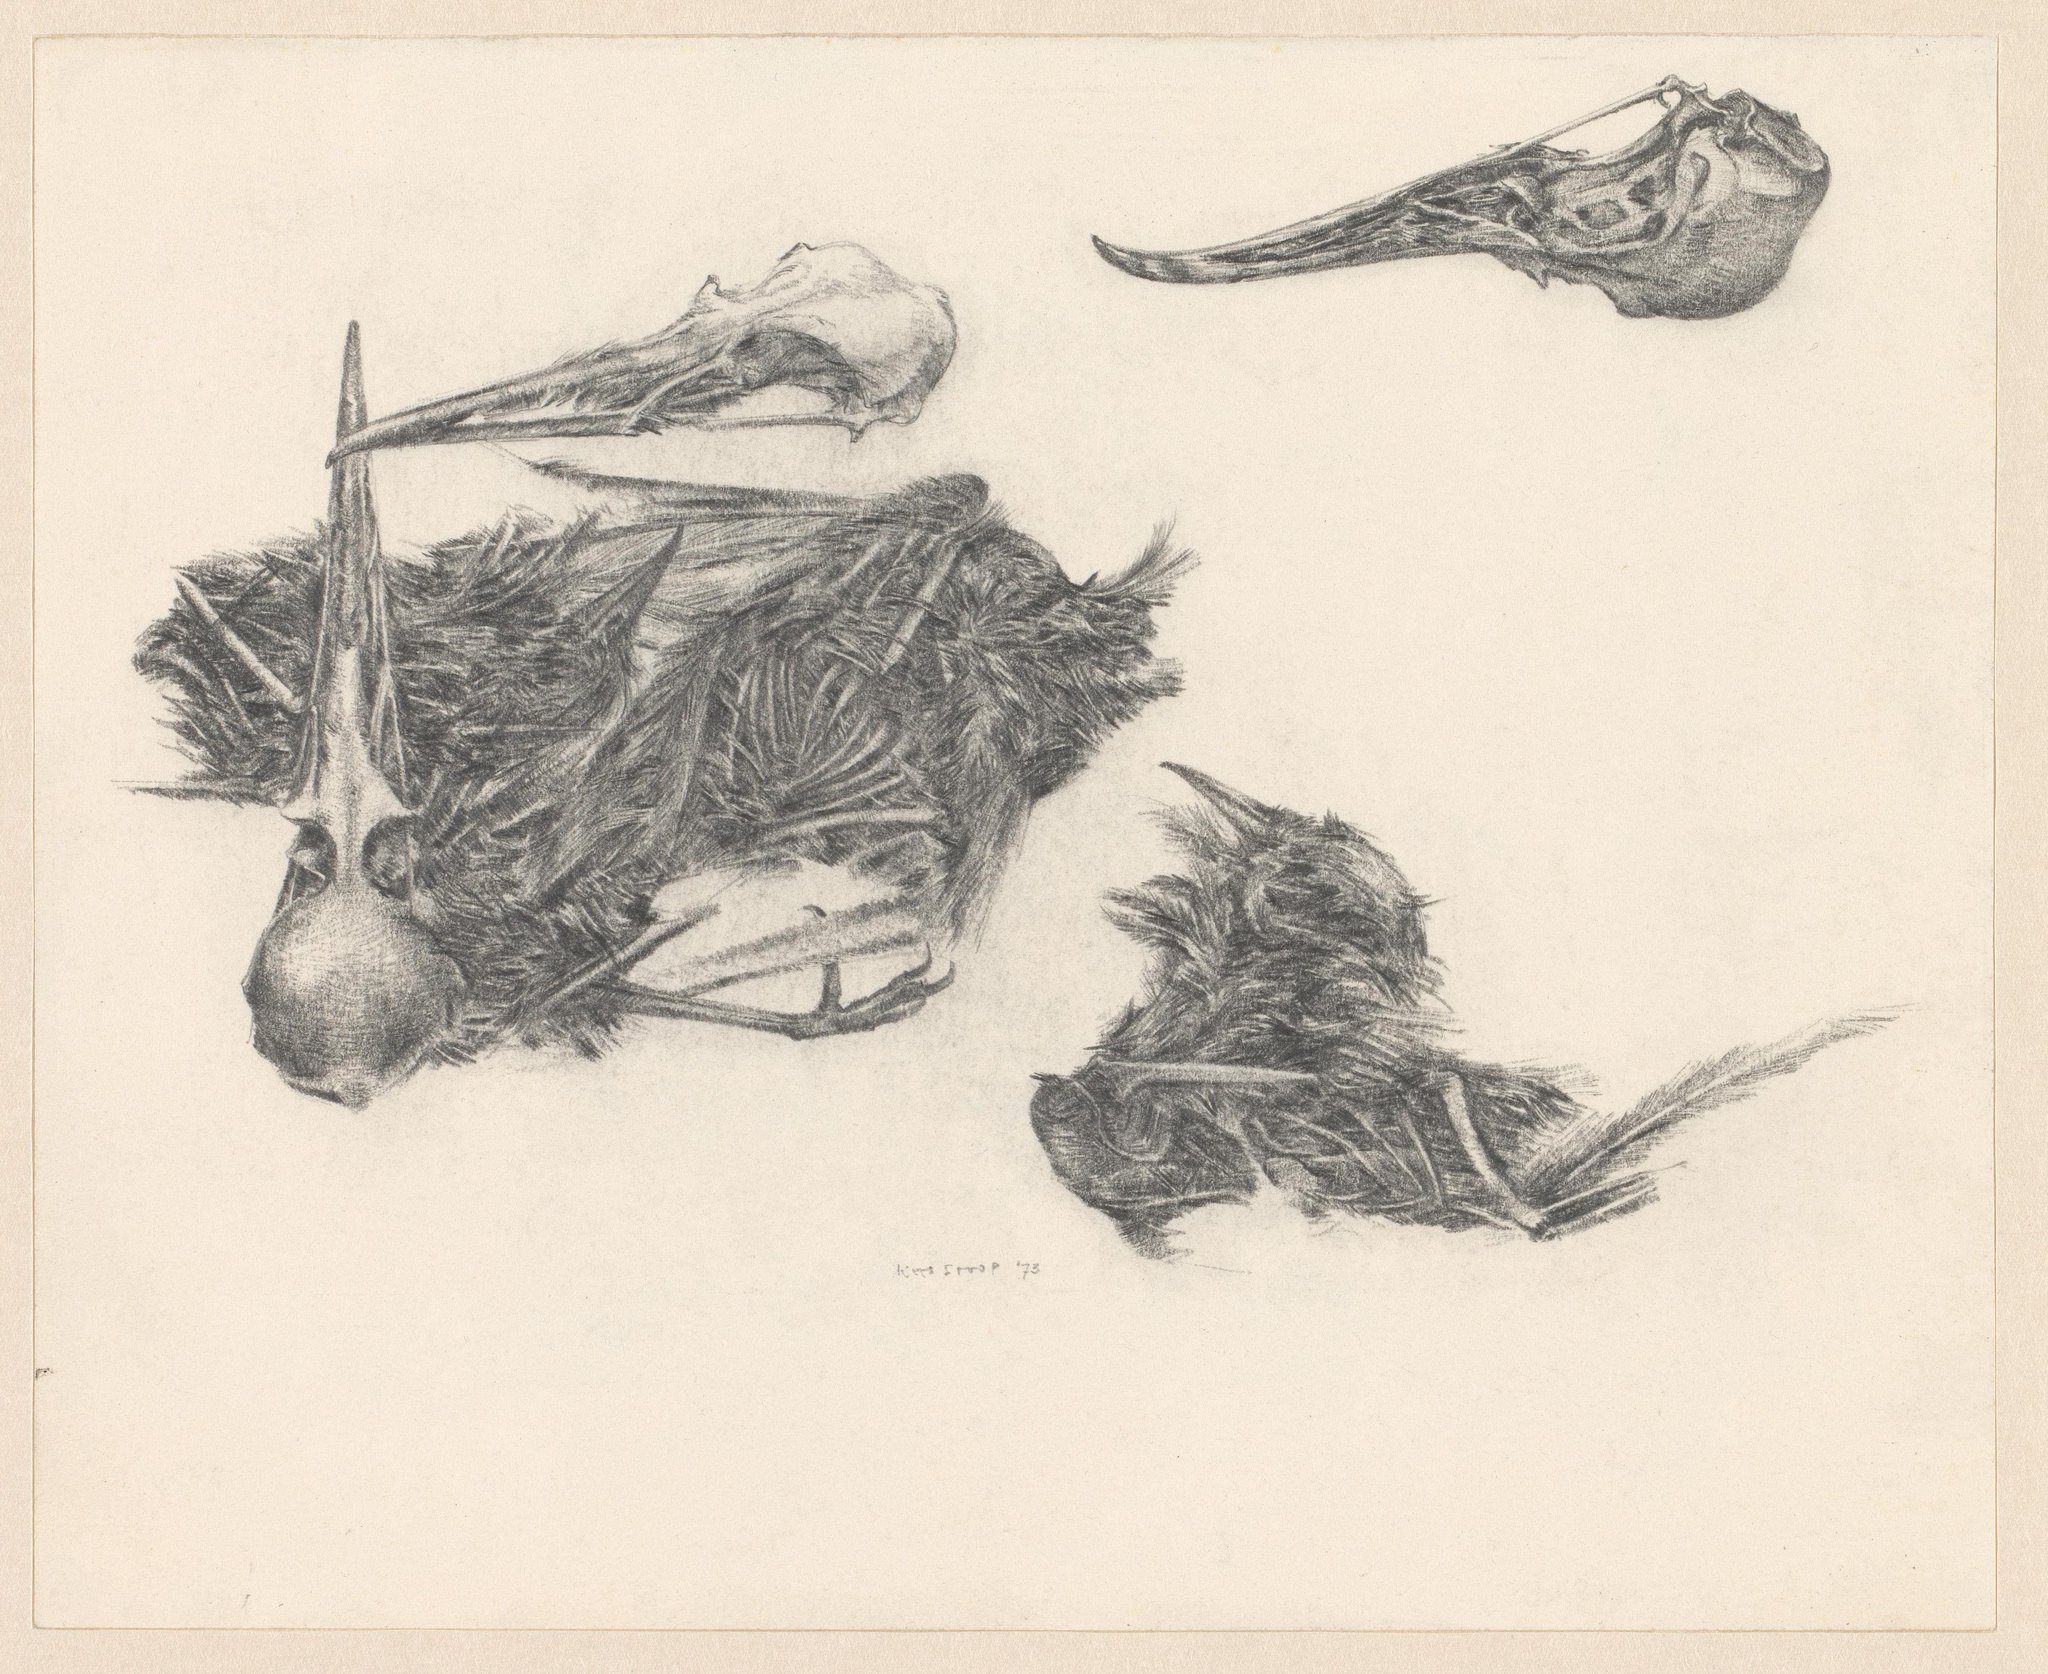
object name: drawing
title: Vogelskeletten en -schedels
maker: kees stoop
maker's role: draughtsman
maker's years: 1929-2019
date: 1973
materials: paper, pencil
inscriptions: signature and date: ‘KEES STOOP '73’